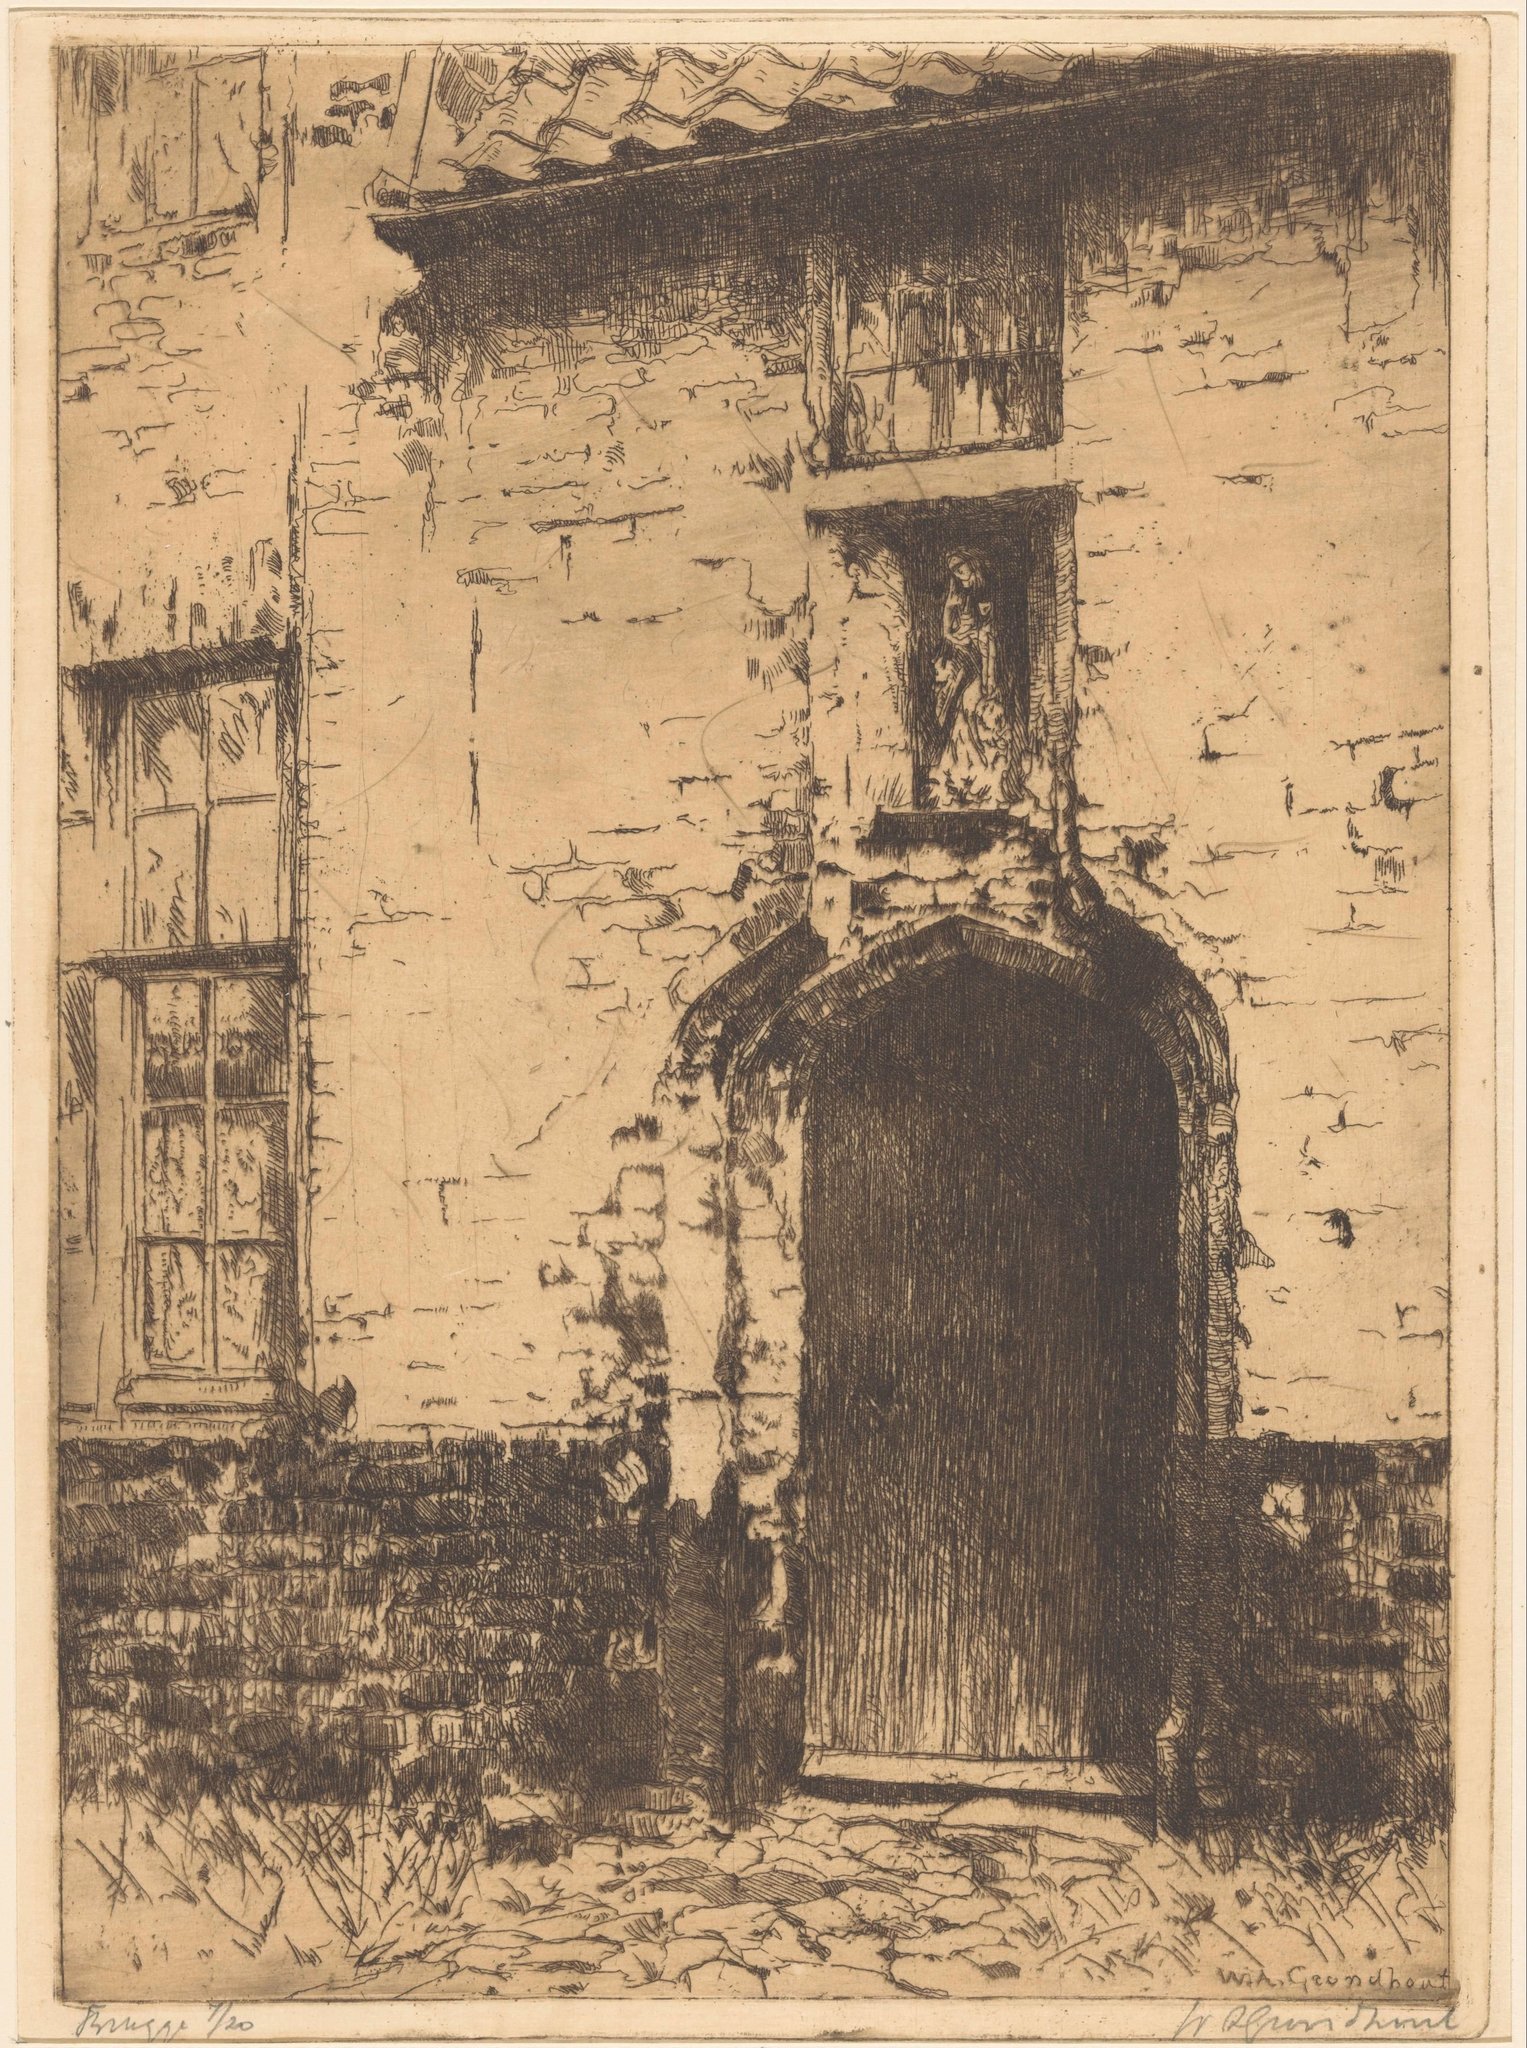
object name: print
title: Brugge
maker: willem adrianus grondhout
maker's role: draughtsman, painter, print maker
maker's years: 1878-1934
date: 1888-1934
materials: paper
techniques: etching, intaglio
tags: gate, entrance, piece of sculpture, reproduction of a piece of sculpture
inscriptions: collector's mark: Lugt 2228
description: Een poort van een huis in het Begijnhof in Brugge. Boven de poort een beeld in een nis.